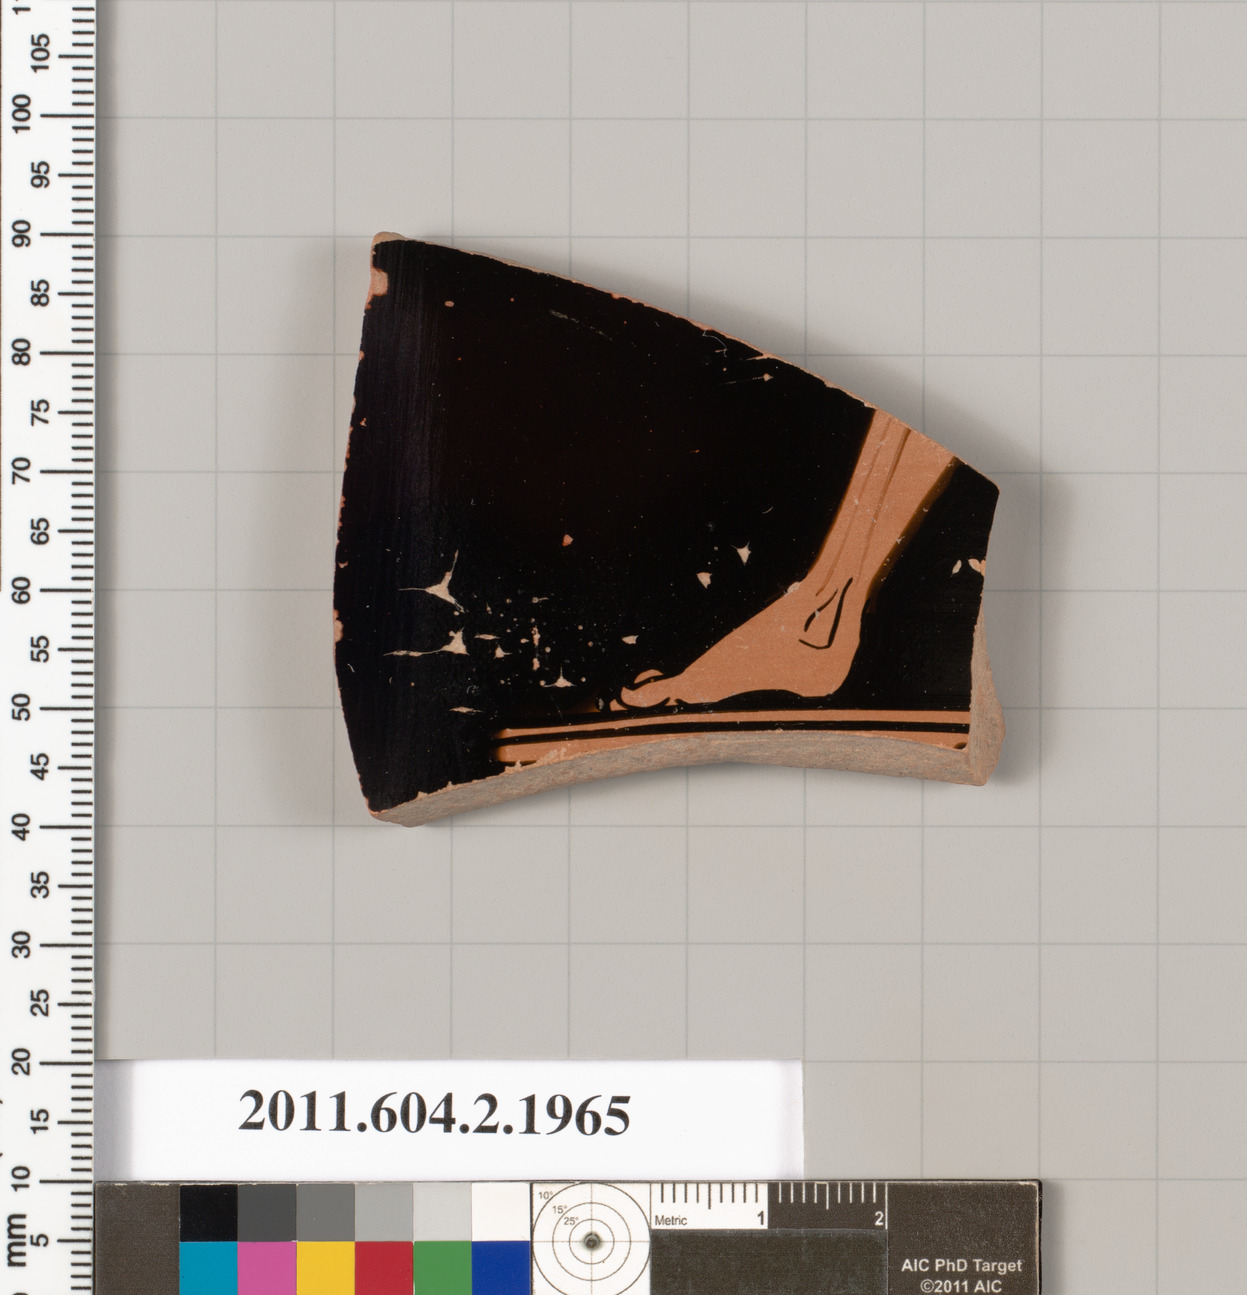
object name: krater fragment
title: Terracotta fragment of a krater (bowl for mixing wine and water)?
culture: greek, attic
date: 480-470 BCE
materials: terracotta